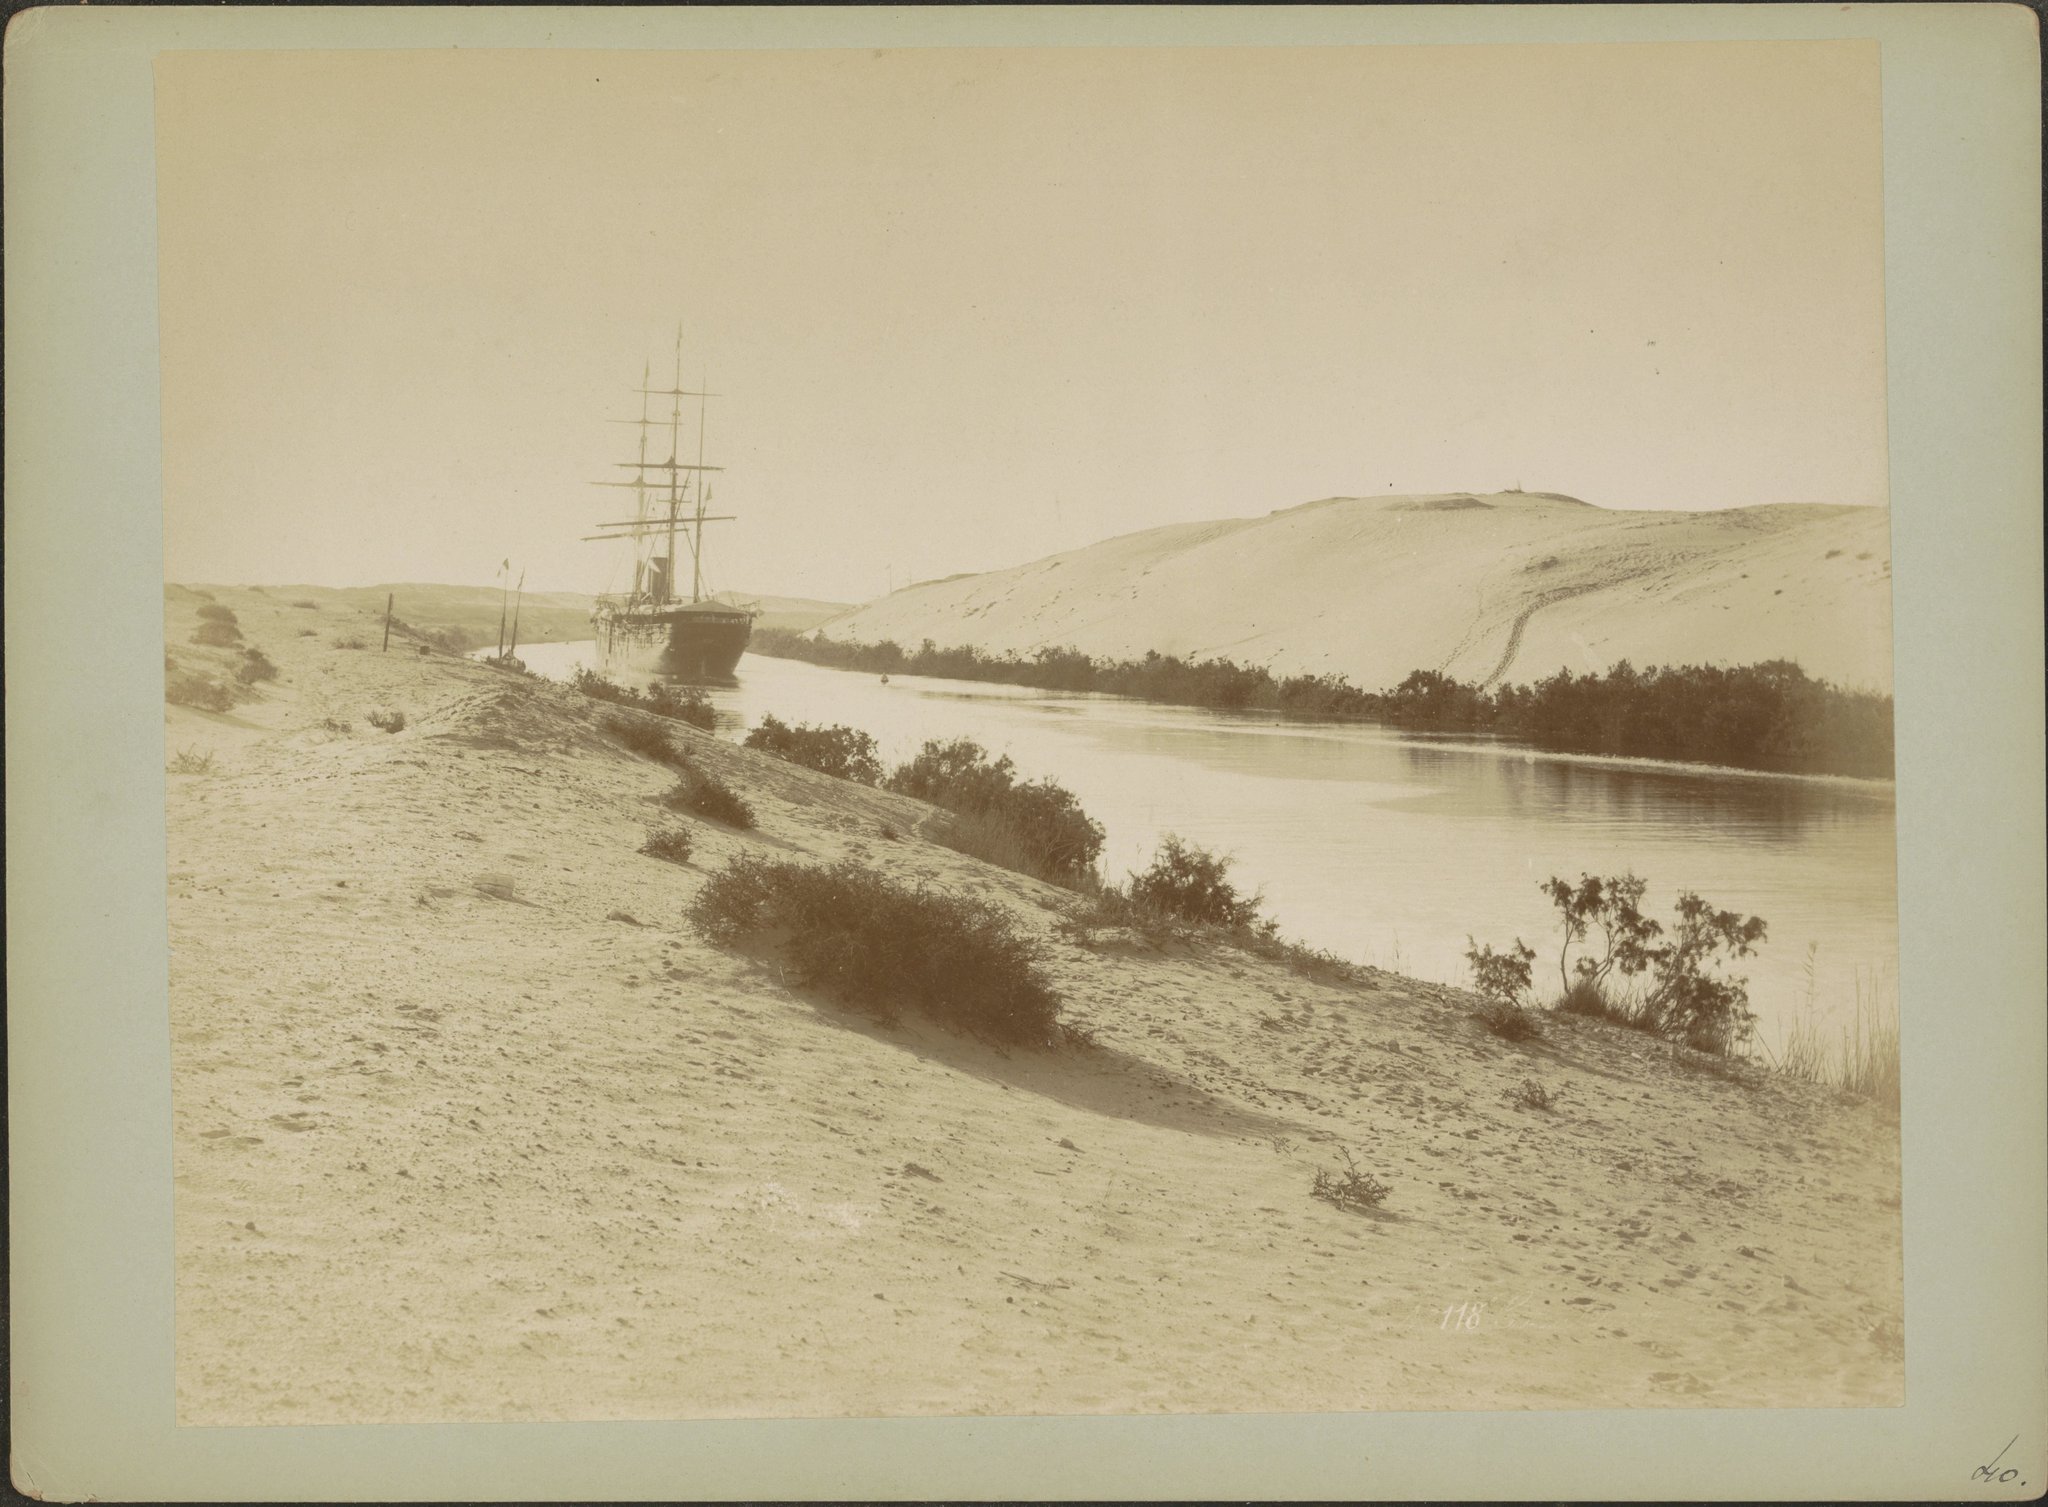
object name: album leaf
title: Schip op het Suezkanaal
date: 1870-1890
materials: cardboard, paper, photographic support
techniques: albumen print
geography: suez canal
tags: sailing-ship, sailing-boat, canal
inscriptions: inscription: ‘Kanaal v. Suez.’, number: ‘N. 118 [...]’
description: Onderdeel van Reisalbum met foto's van bezienswaardigheden in Marseille, Port Said, Aden, Bombay, Colombo, Singapore en Nederlands-Indië.